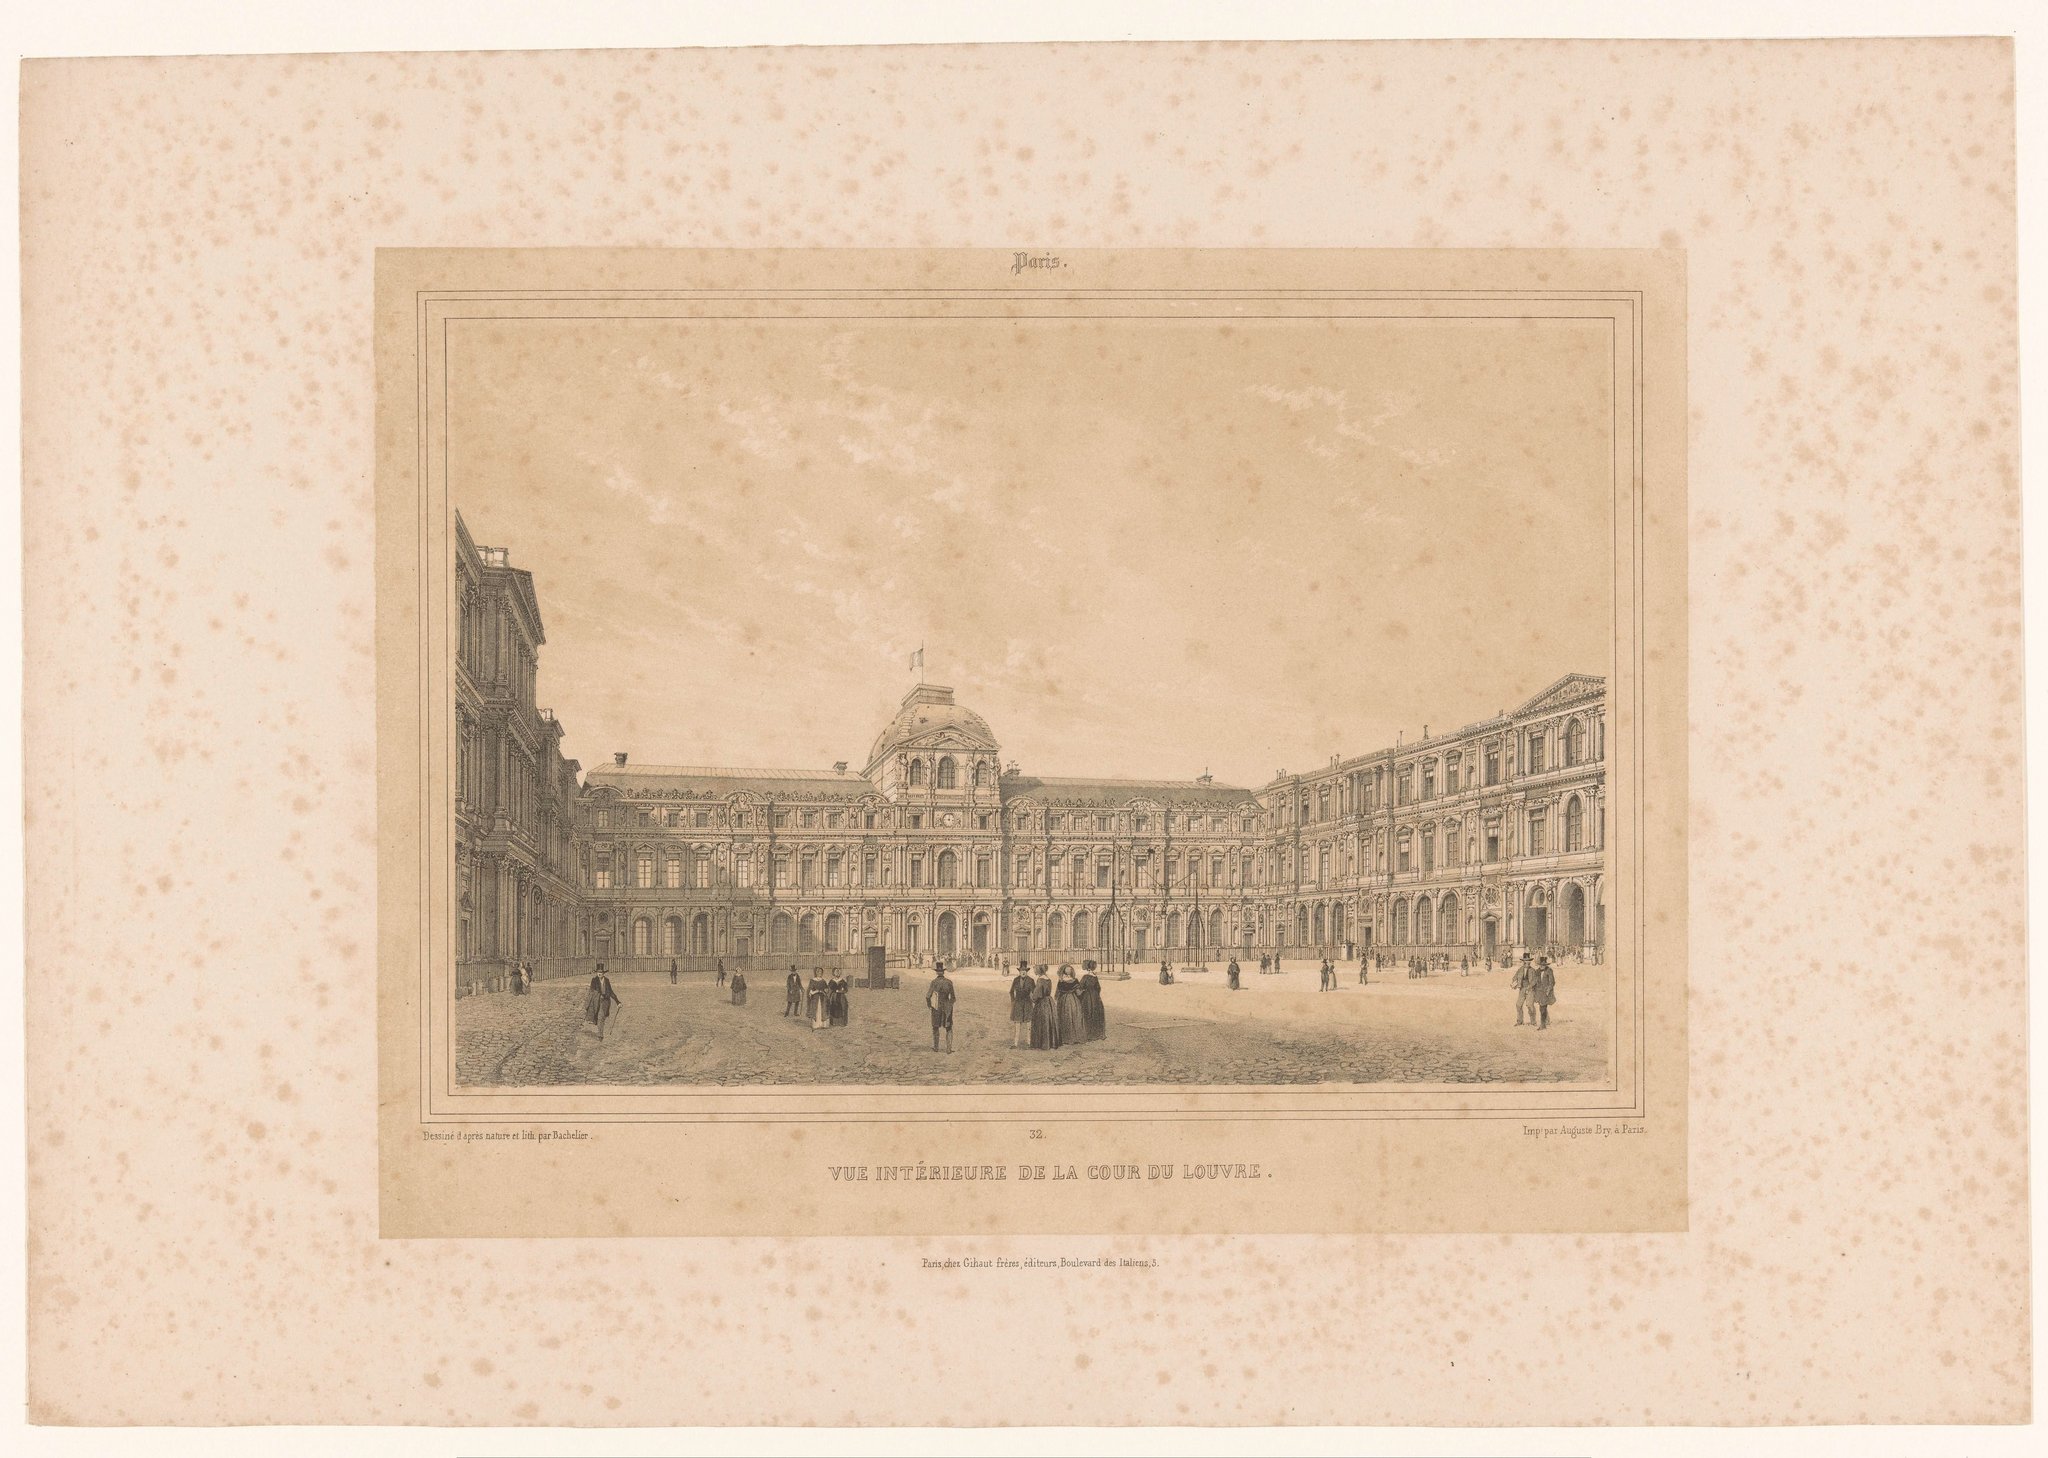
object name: print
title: Zicht op de Cour Carrée van het Louvre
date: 1845-1847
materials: paper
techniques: tone lithography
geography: paris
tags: palace, courtyard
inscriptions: collector's mark: Lugt 2228a